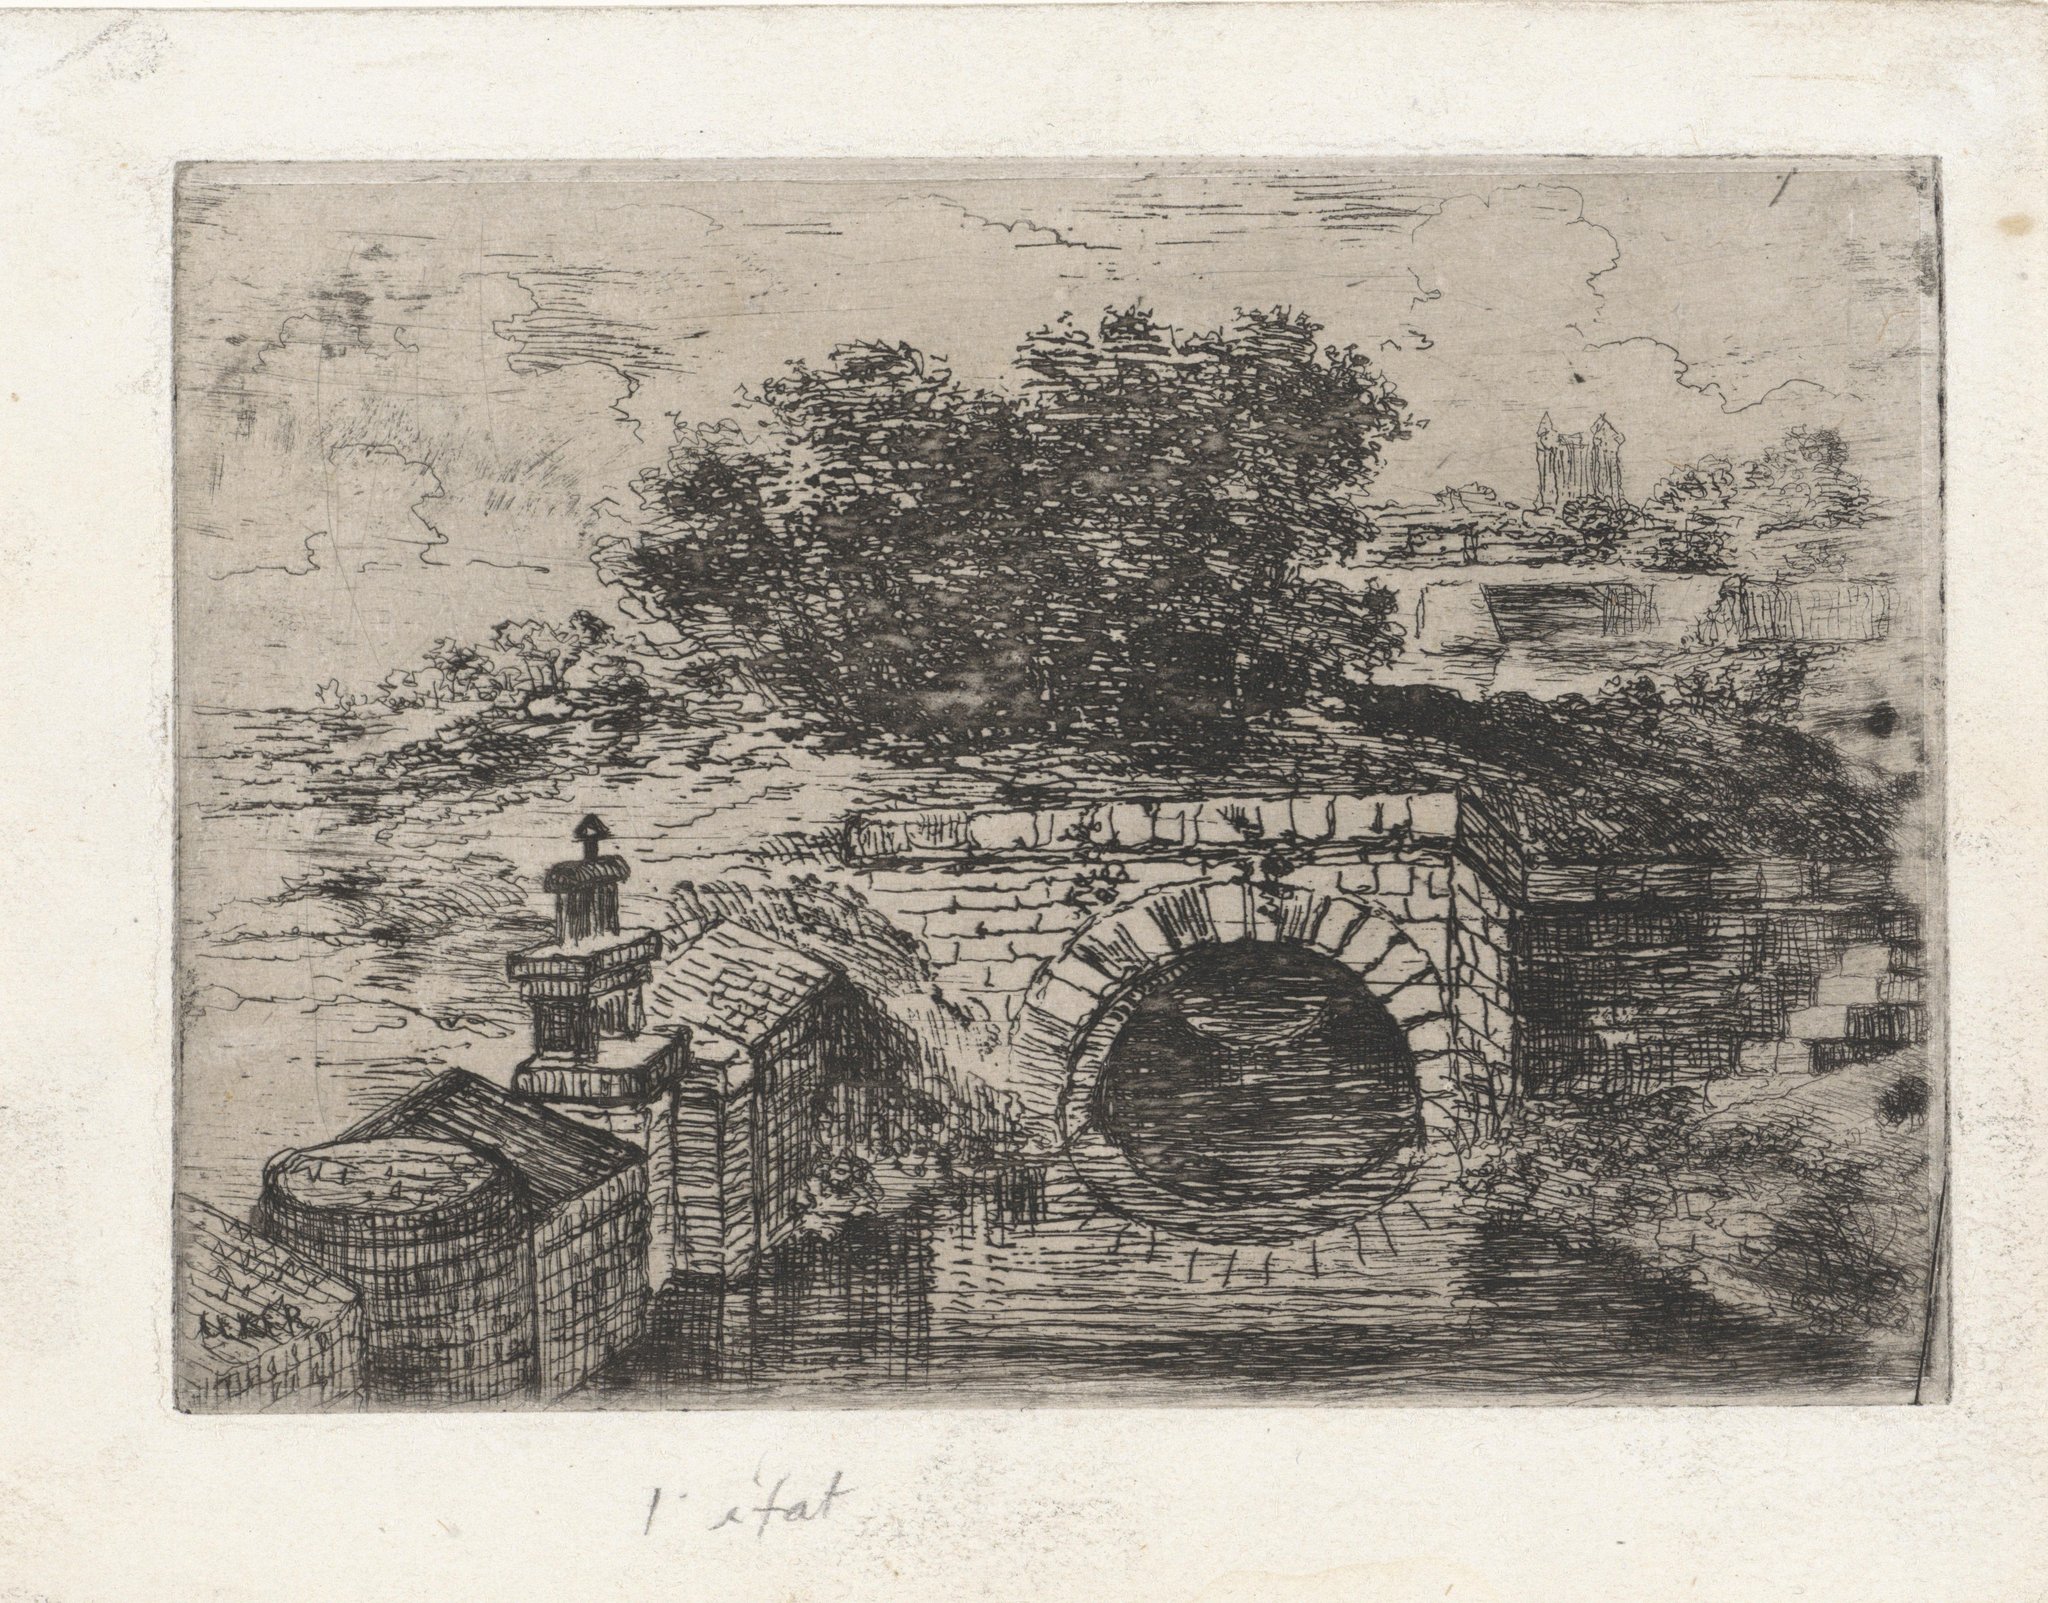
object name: print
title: Rivier de Jeker bij Maastricht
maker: alexander schaepkens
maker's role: draughtsman, print maker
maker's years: 1815-1899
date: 1830-1899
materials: paper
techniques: etching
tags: river, maastricht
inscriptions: collector's mark: Lugt 2228